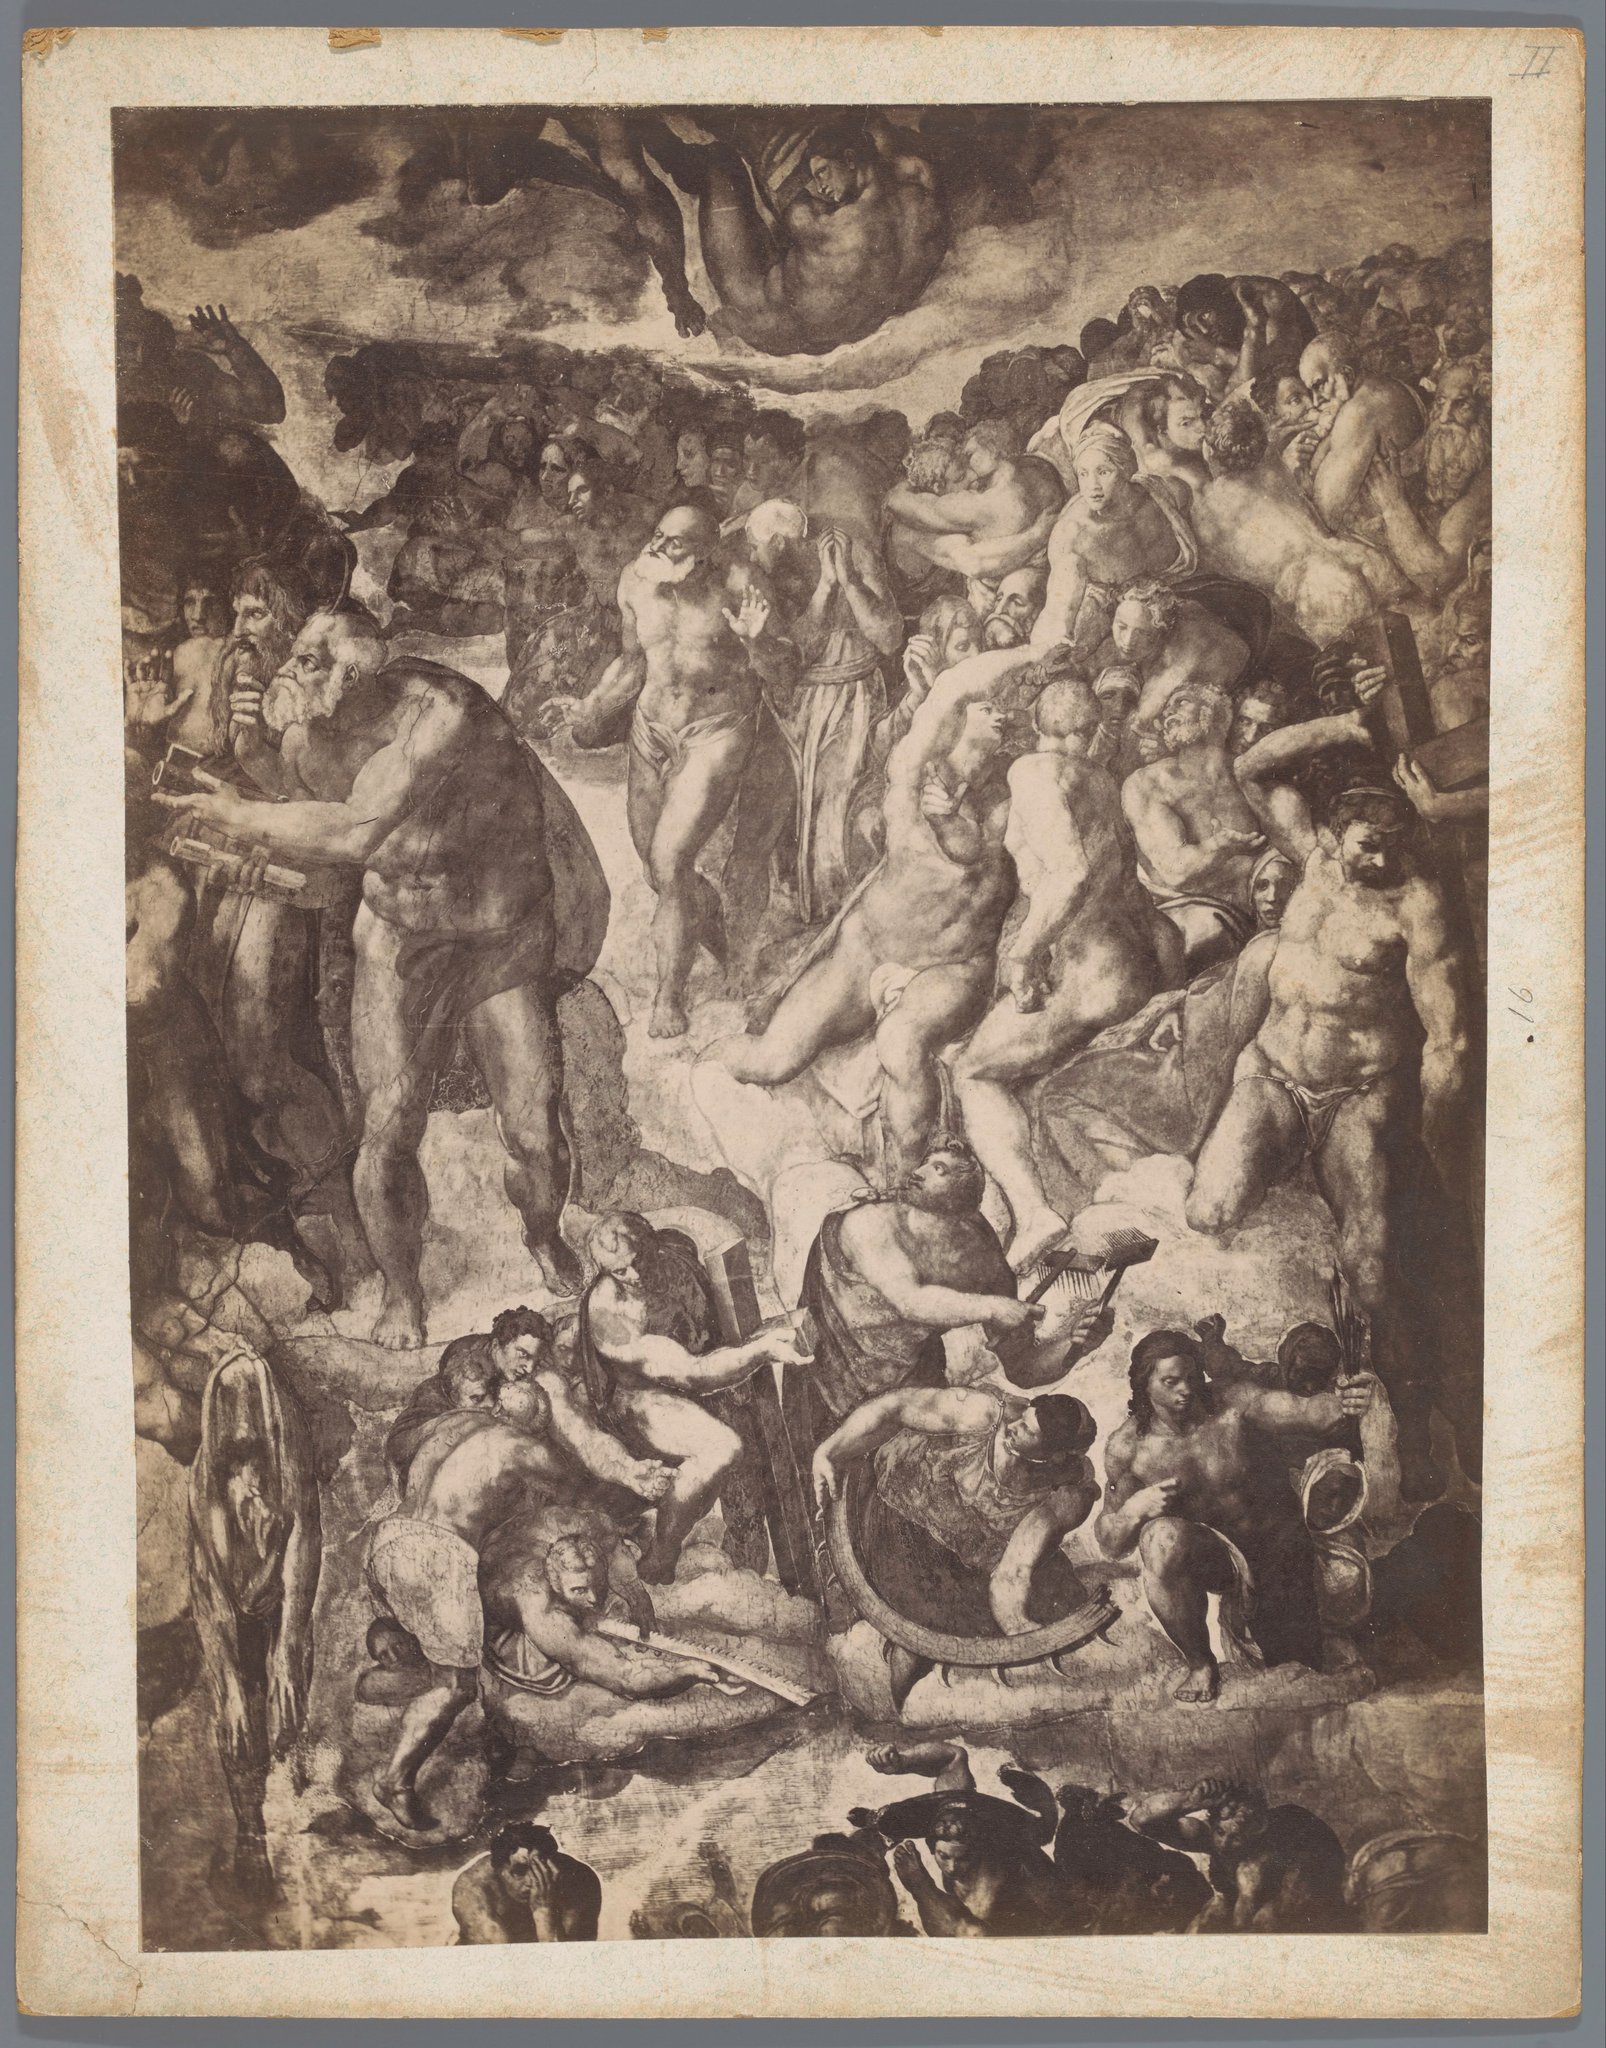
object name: photograph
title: Fotoreproductie van een deel van de fresco's op de muur van de Sixtijnse Kapel te Vaticaanstad door Michelangelo, voorstellende het Laatste Oordeel met Petrus en heiligen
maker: Anonymous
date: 1875-1900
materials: cardboard, photographic support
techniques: albumen print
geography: vatican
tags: last judgement, saints, the apostle peter, first bishop of rome; possible attributes: book, cock, (upturned) cross, (triple) crozier, fish, key, scroll, ship, tiara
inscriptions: collector's mark: Lugt 3937